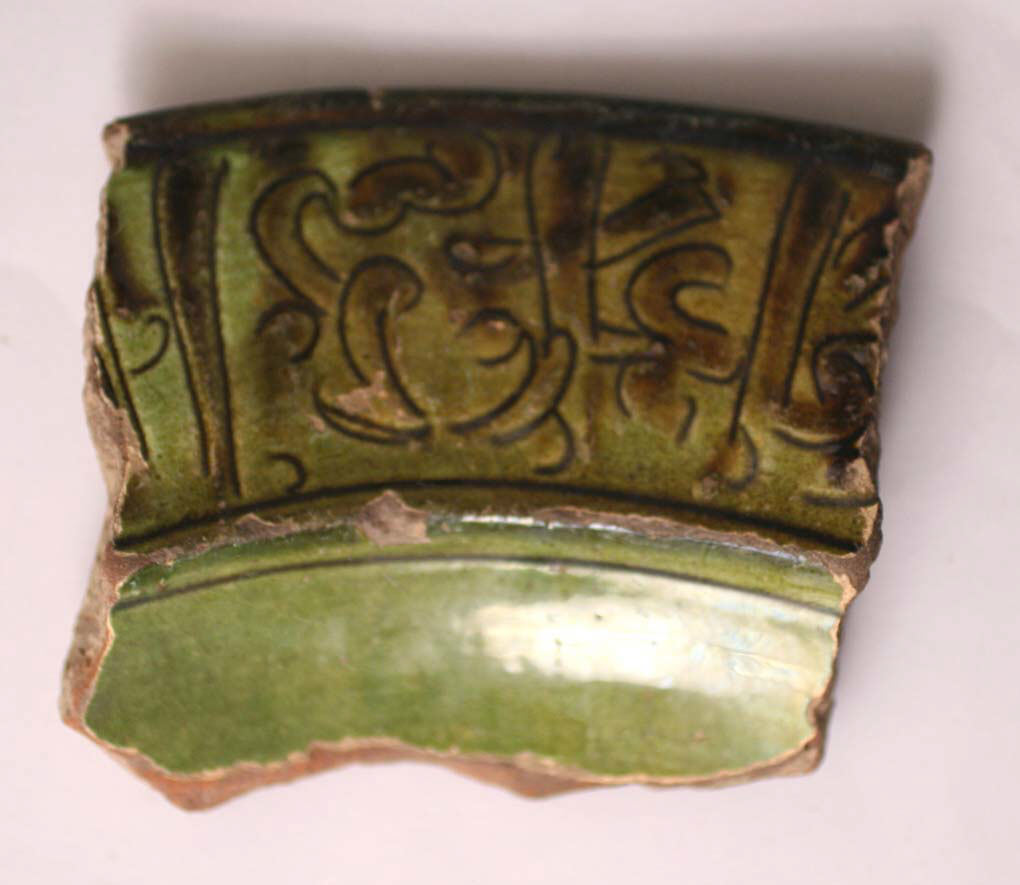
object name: ceramic fragment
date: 1301-1500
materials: earthenware, glaze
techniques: coloring, incising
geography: egypt